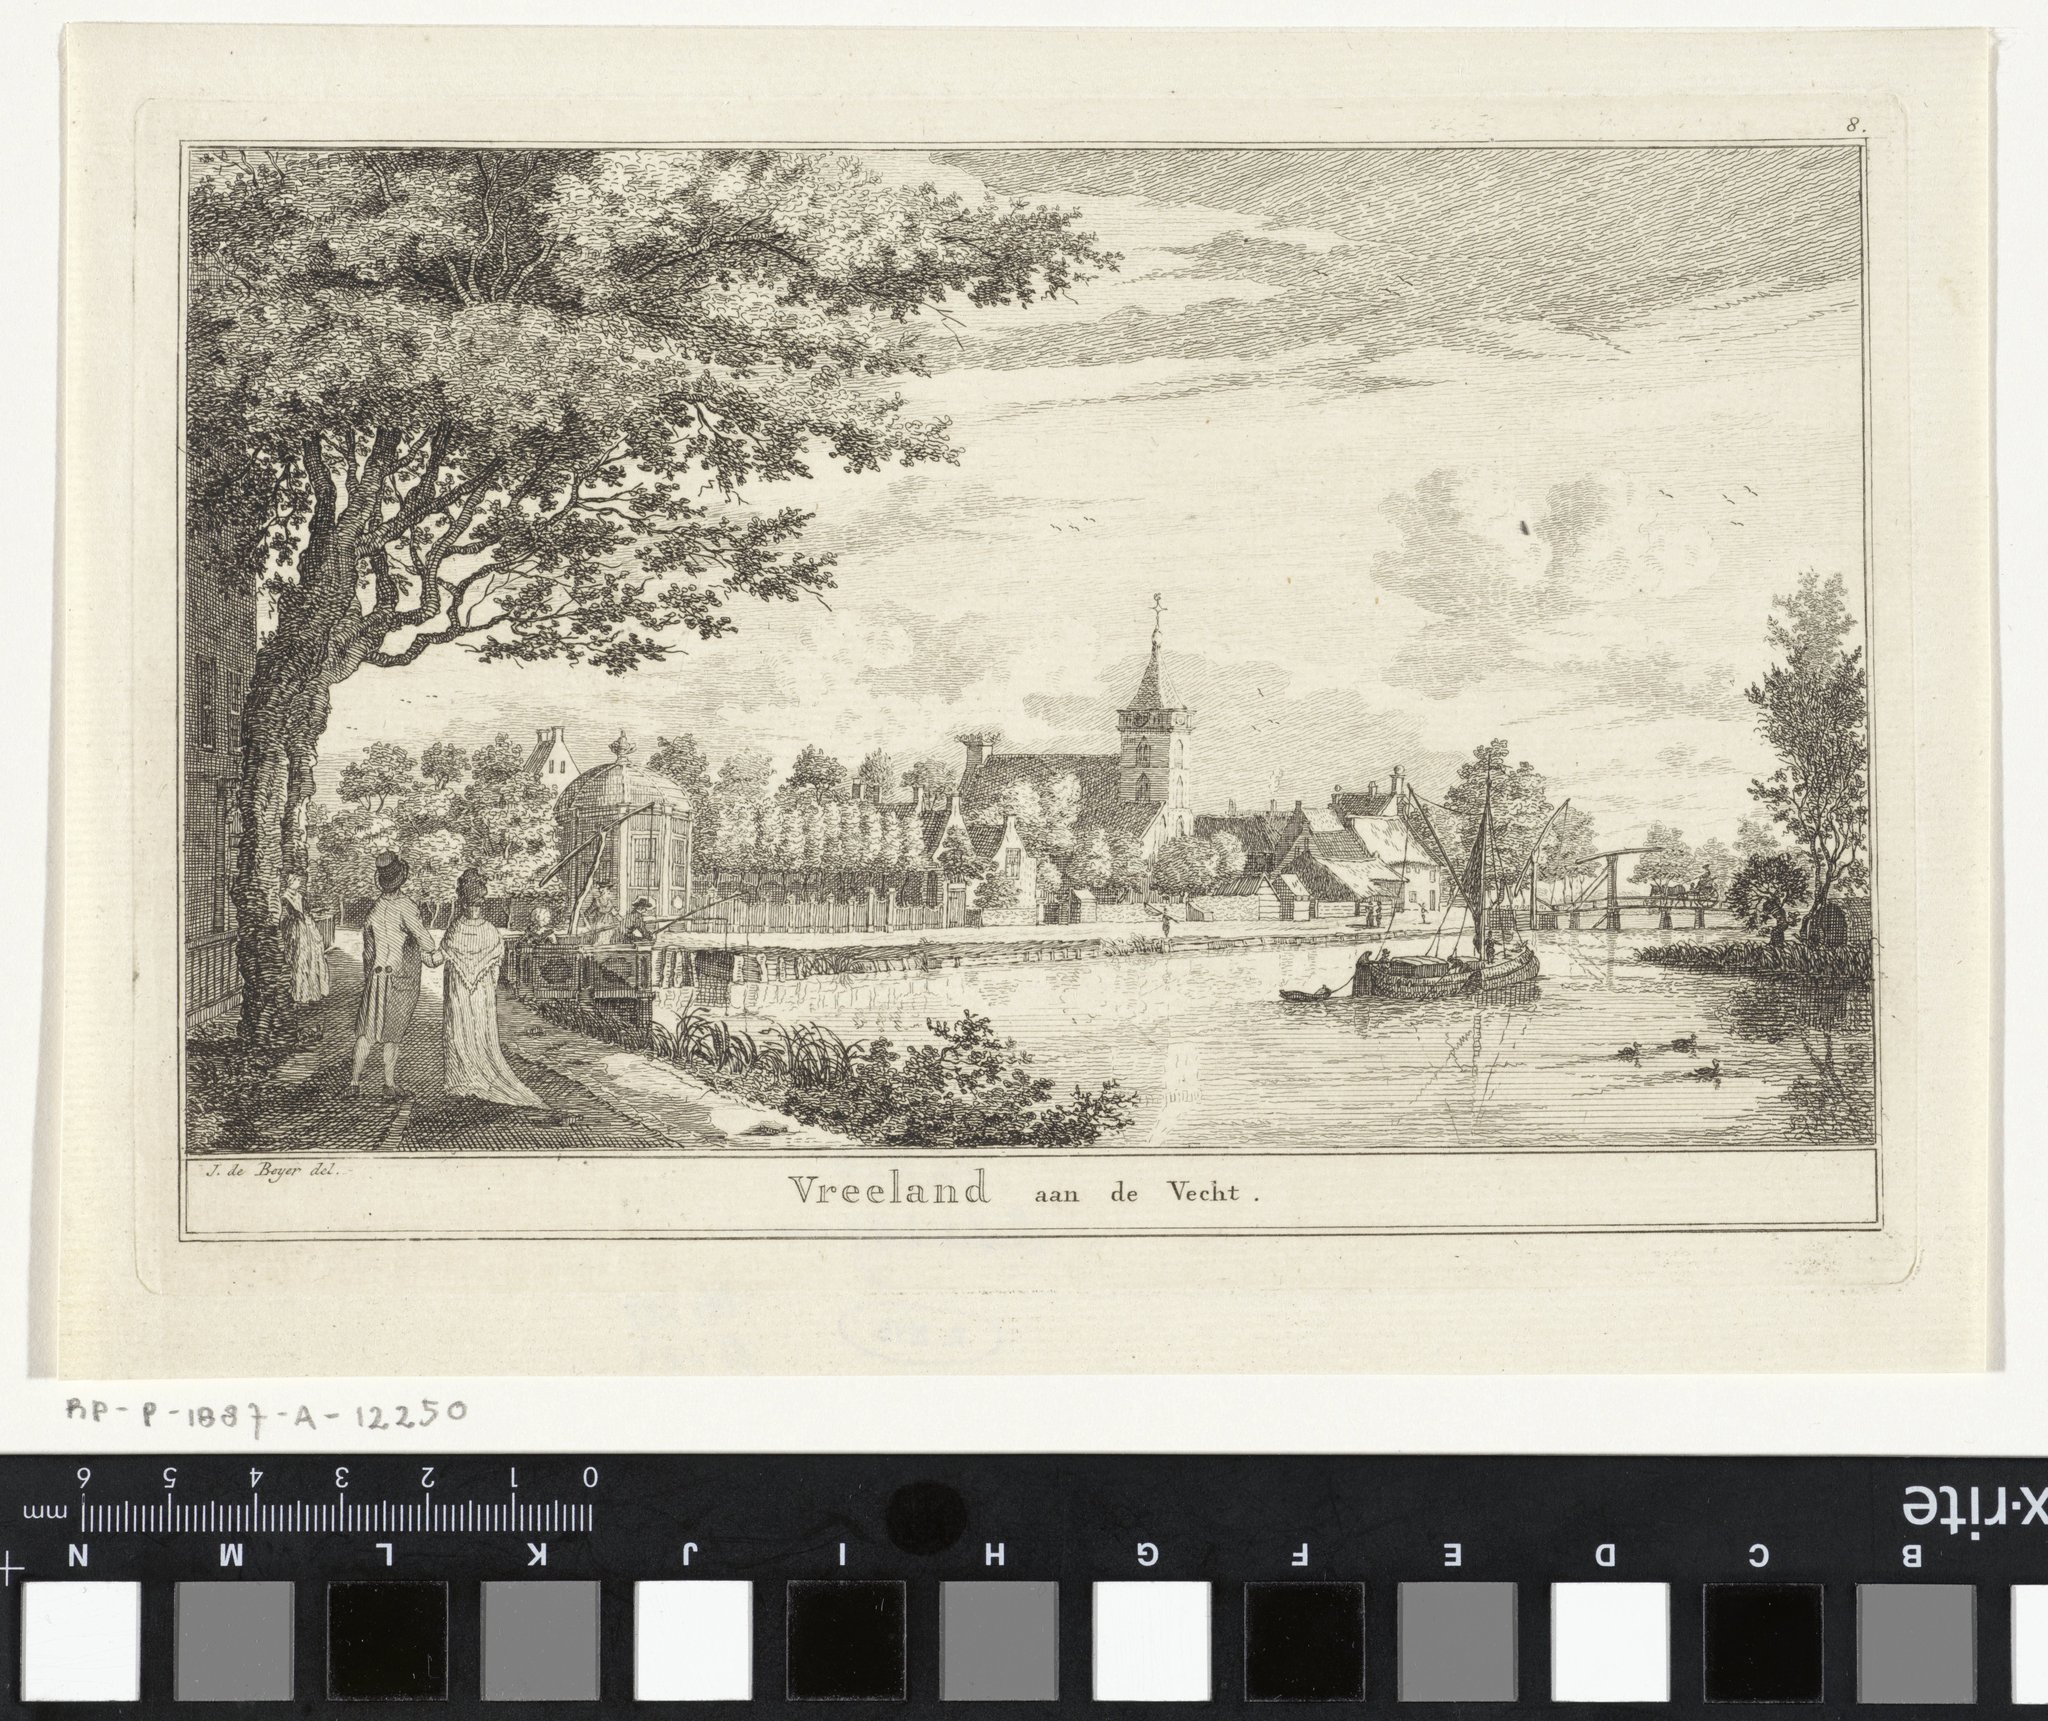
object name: print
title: Gezicht op Vreeland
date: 1746-1786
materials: paper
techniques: etching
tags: walking, hiking (recreation), angling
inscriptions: collector's mark: Lugt 2228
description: Gezicht op het dorp Vreeland, gelegen aan de rivier de Vecht. Op de voorgrond een dame en een heer, en iets verderop een hengelaar. Op de Vecht vaart een boot.